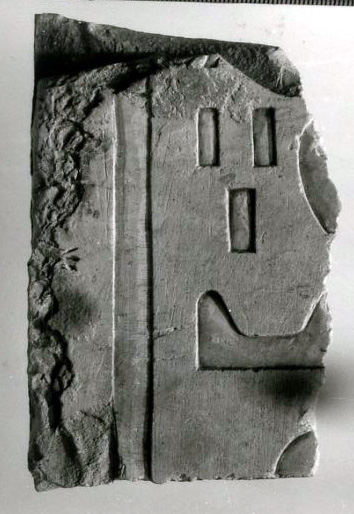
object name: relief fragment, tomb of meketre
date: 1981-1975 BCE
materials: limestone, paint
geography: egypt